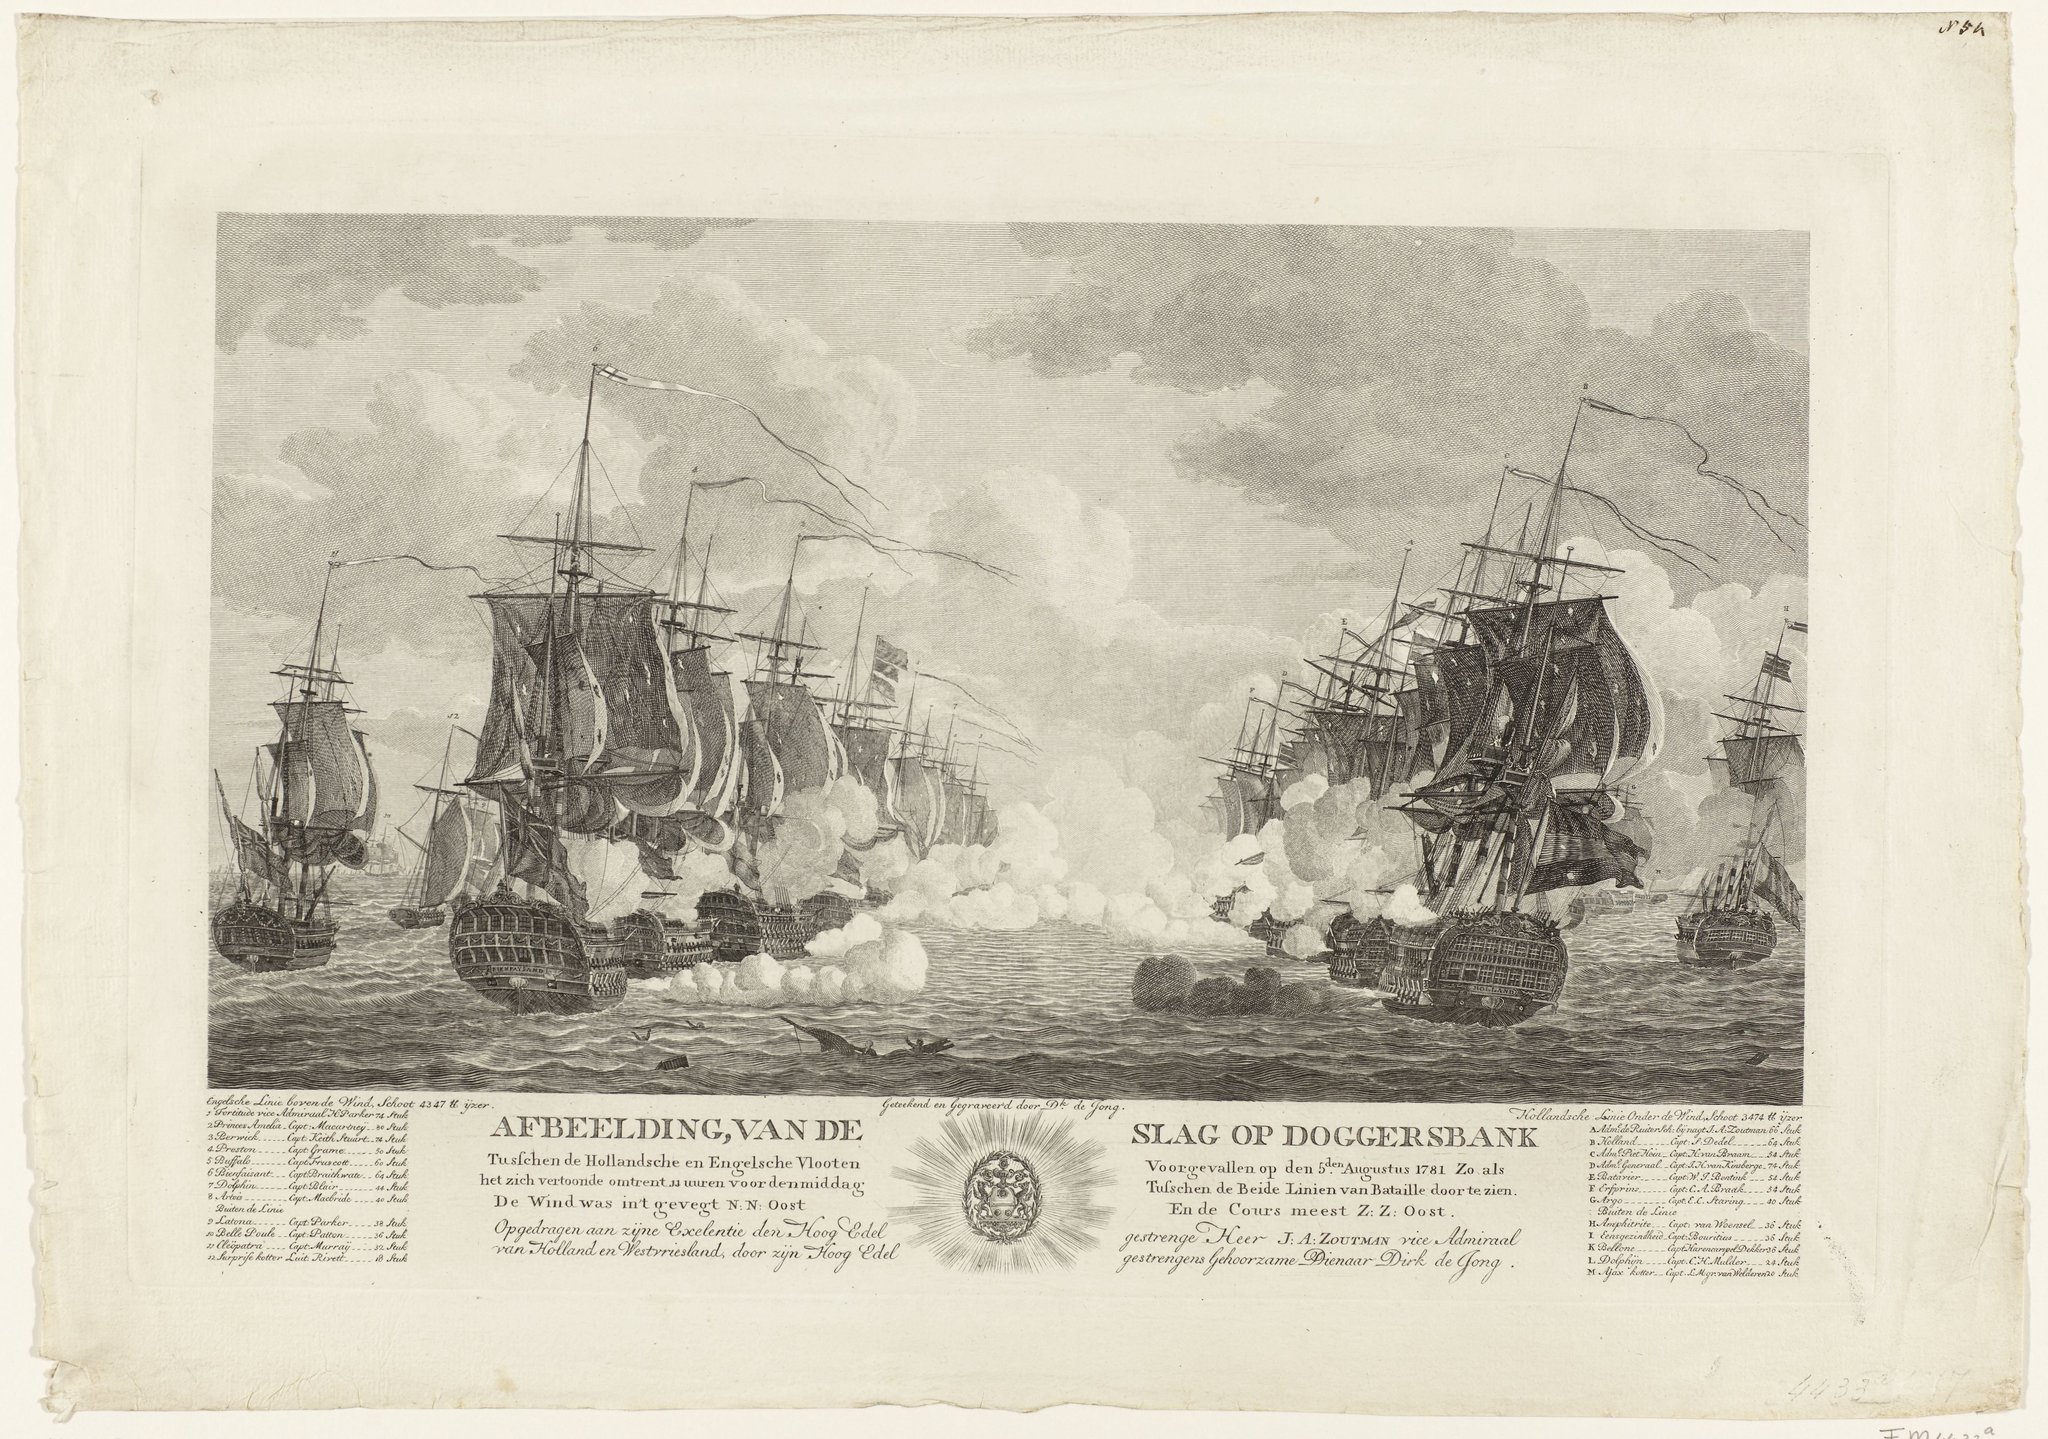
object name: print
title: Zeeslag bij Doggersbank, 1781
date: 1781-1782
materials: paper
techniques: engraving, etching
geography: northern netherlands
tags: the hague, johan arnold zoutman, hyde parker, battle (+ naval force)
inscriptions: collector's mark: Lugt 2228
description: De Nederlandse en Engelse schepen in linie vuren op elkaar bij de aanvang van de zeeslag bij Doggersbank op 5 augustus 1781 tussen de Nederlandse vloot onder schout-bij-nacht Johan Zoutman en de Engelse vloot onder vice-admiraal Hyde Parker. In de marge onderaan de titel, de opdracht en de legenda van de schepen met namen van kapiteins en aantallen stukken en in het midden het stralende wapen van Zoutman.